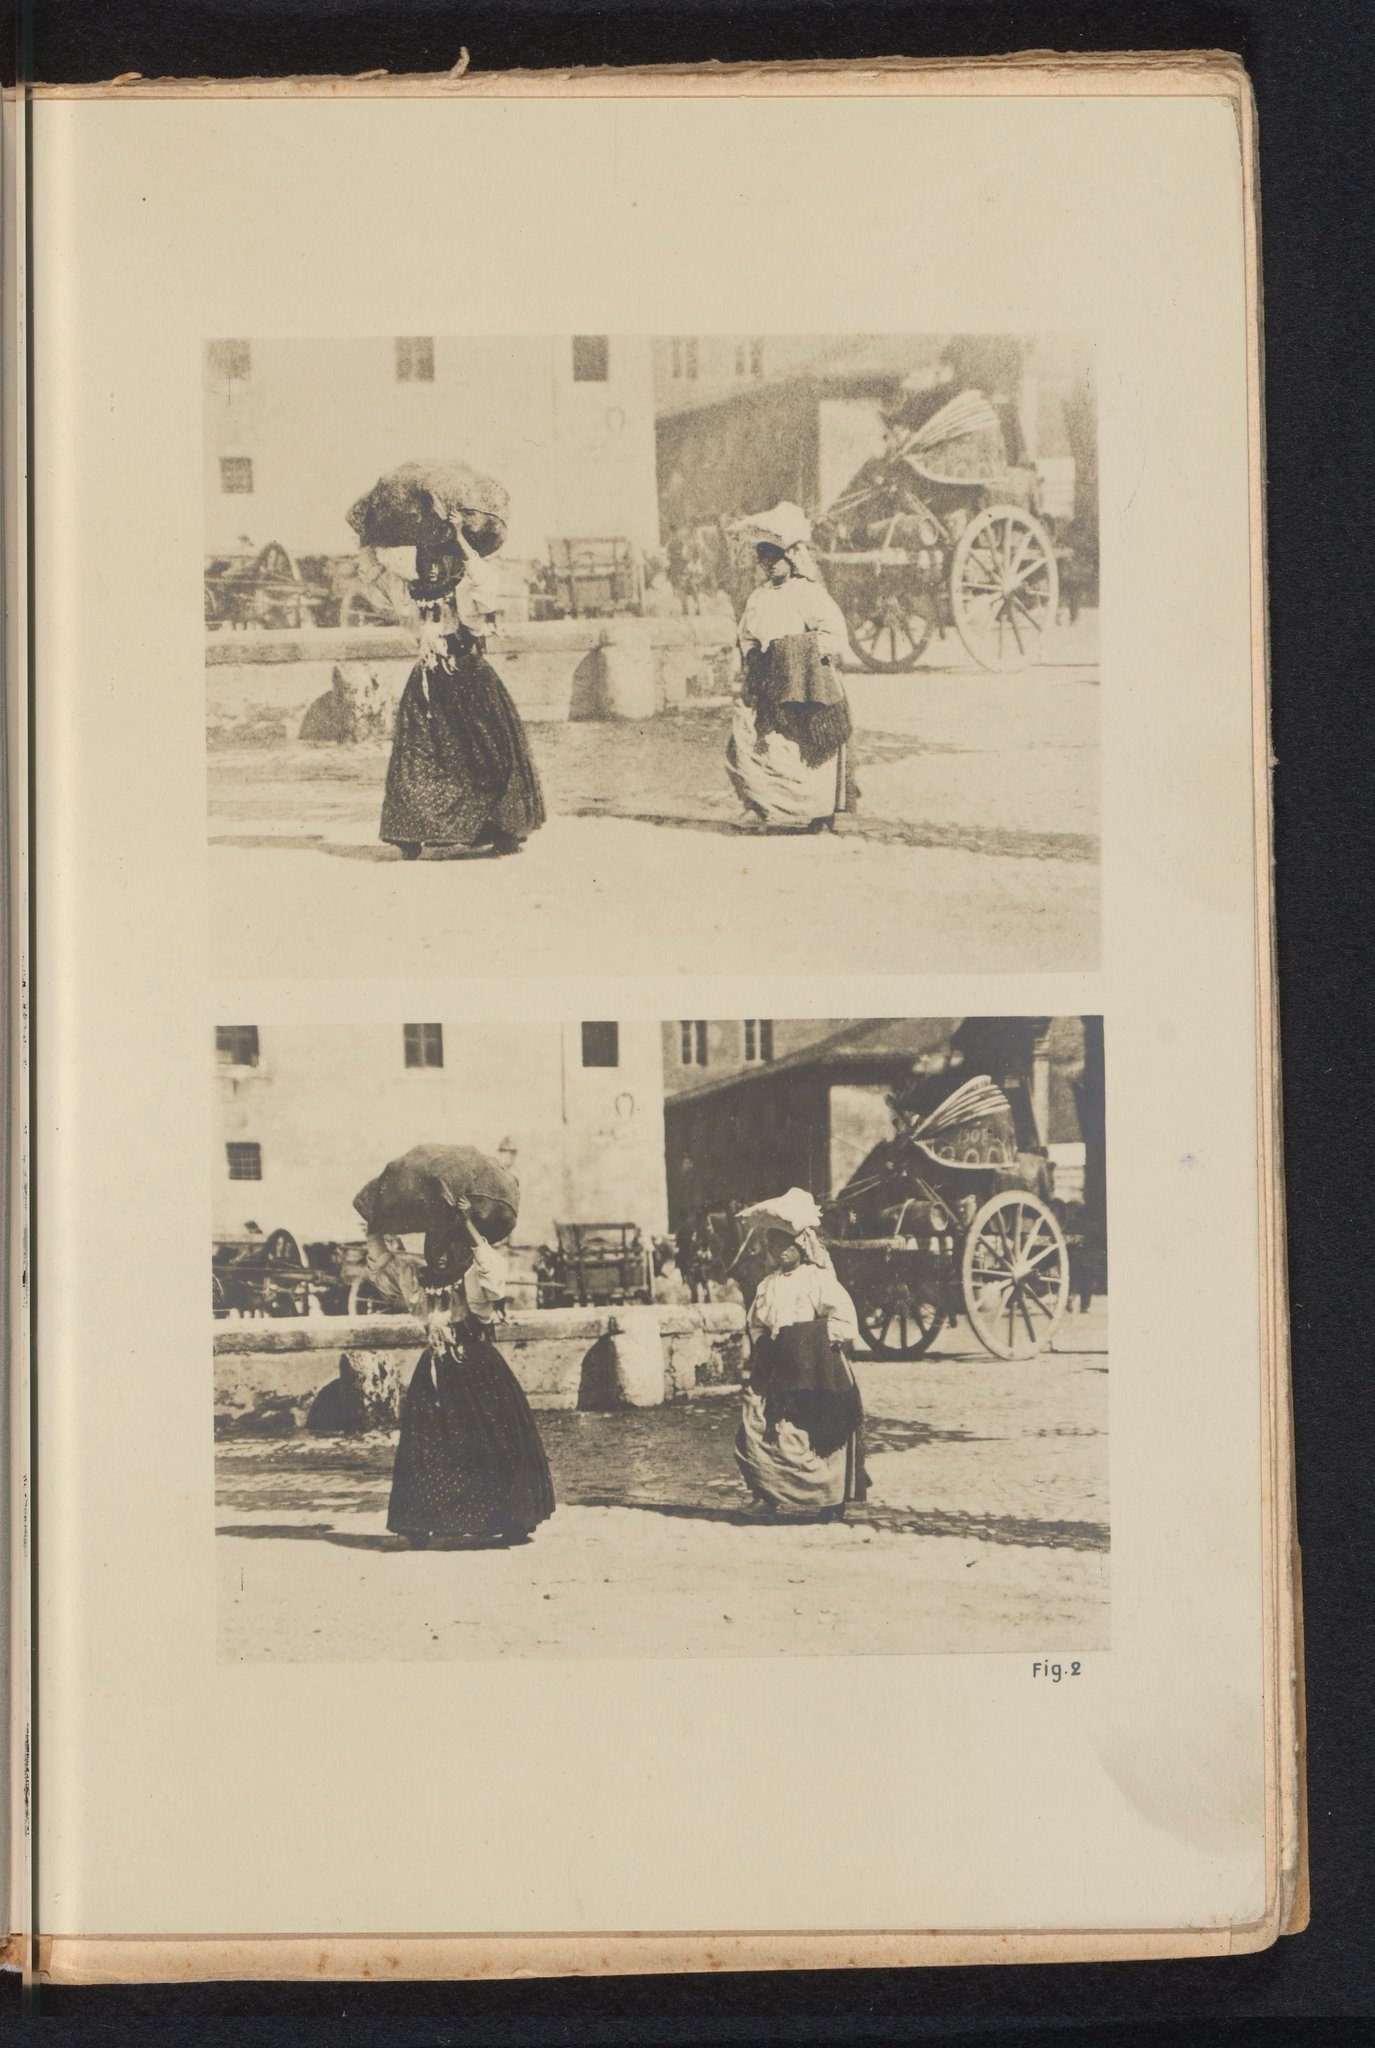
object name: photograph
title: Twee afbeeldingen van twee vrouwen op straat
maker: Anonymous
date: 1902-1912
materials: photographic support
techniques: gelatin silver print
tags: street, carrying something on the head or on the shoulders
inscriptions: number: ‘Fig. 2’